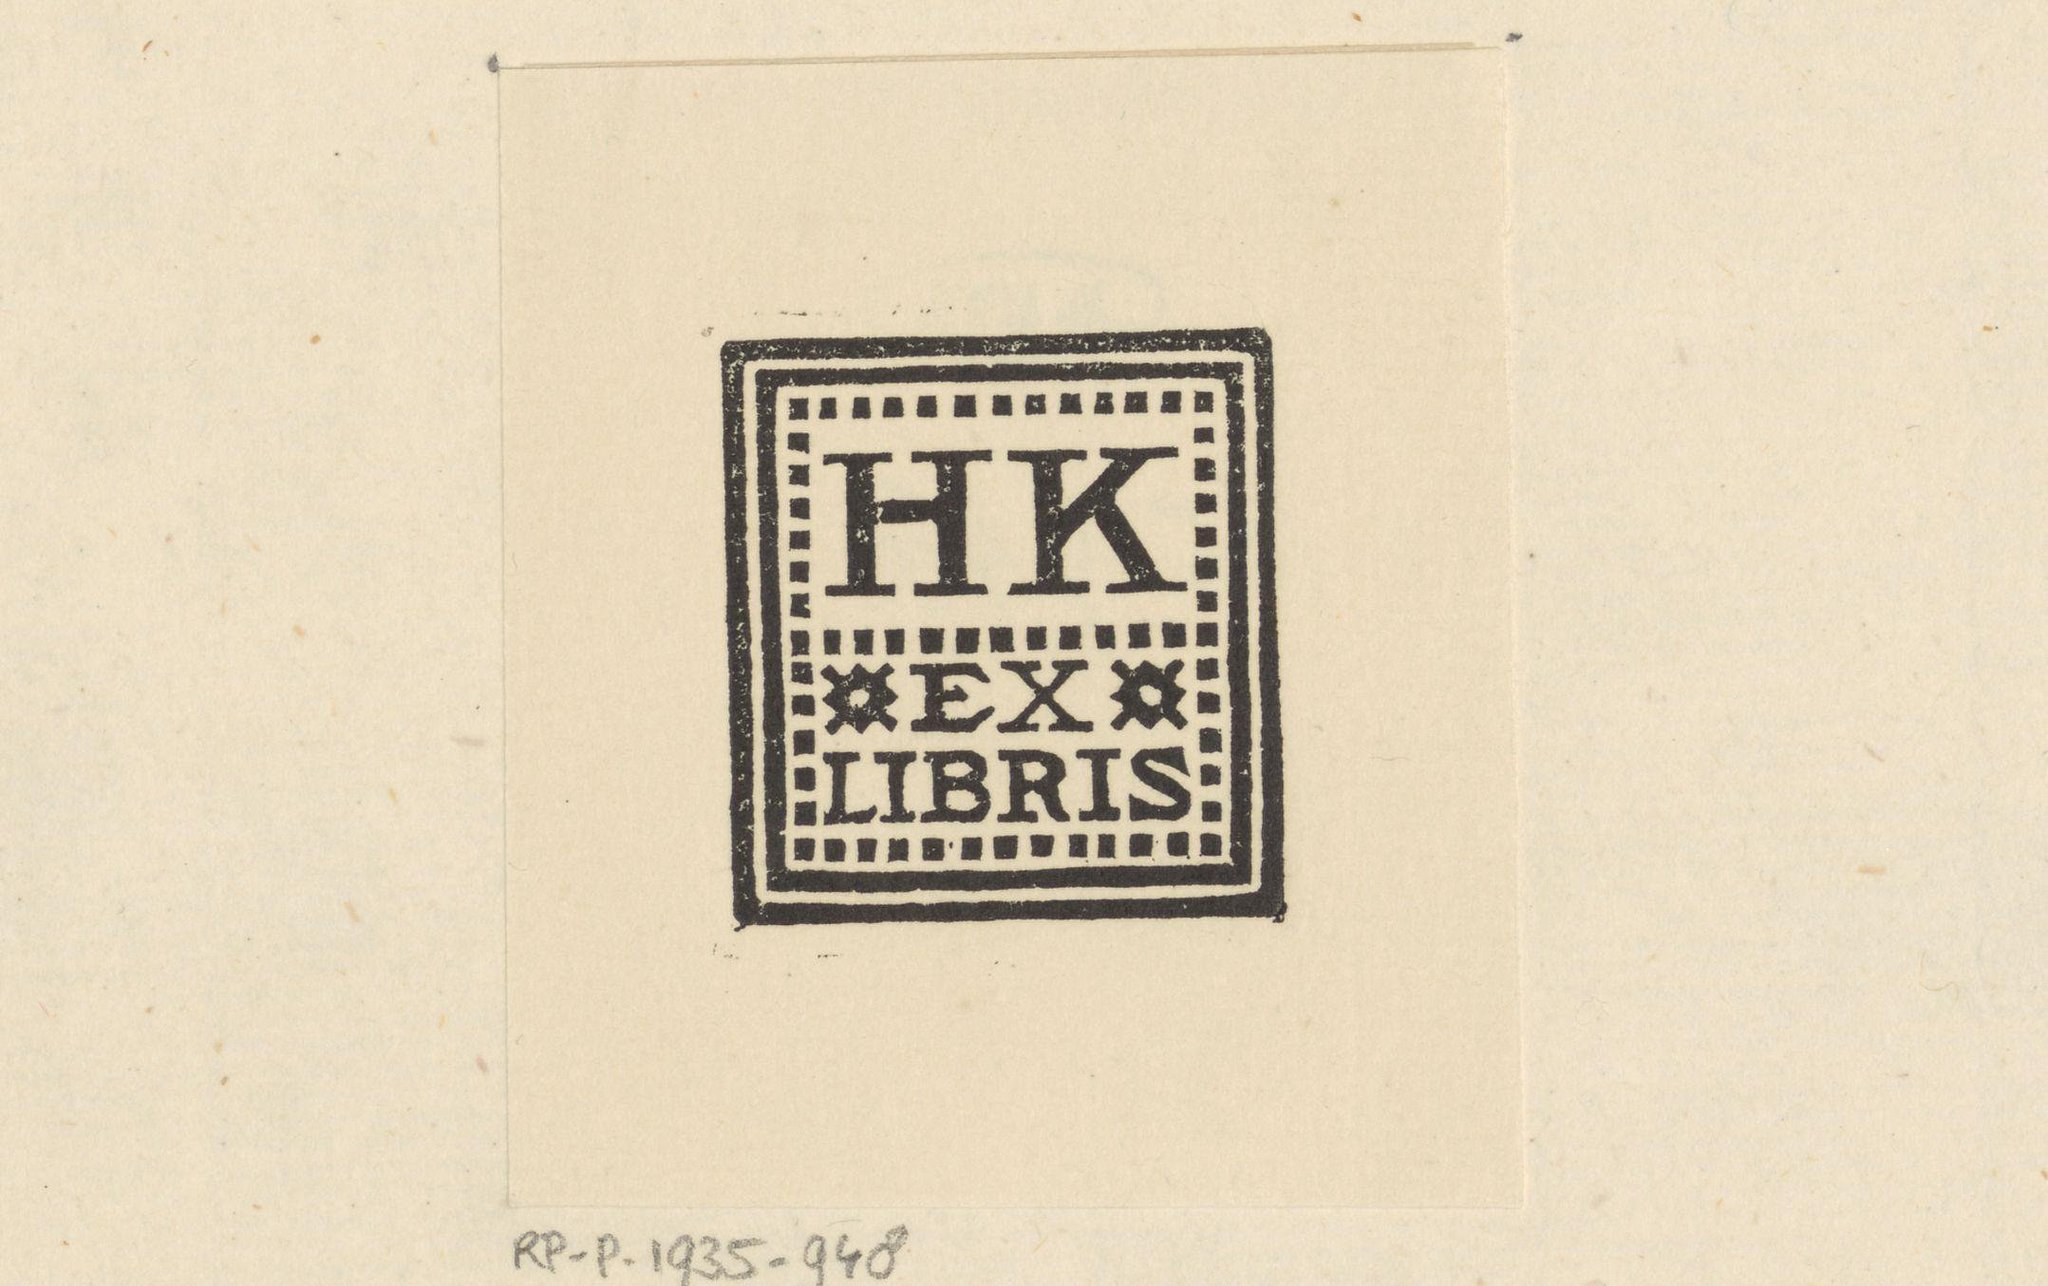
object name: bookplate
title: Ex libris van H.K.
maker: julie de graag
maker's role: draughtsman, print maker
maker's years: 1877-1924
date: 1887-1924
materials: paper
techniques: woodcut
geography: netherlands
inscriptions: collector's mark: Lugt 2228